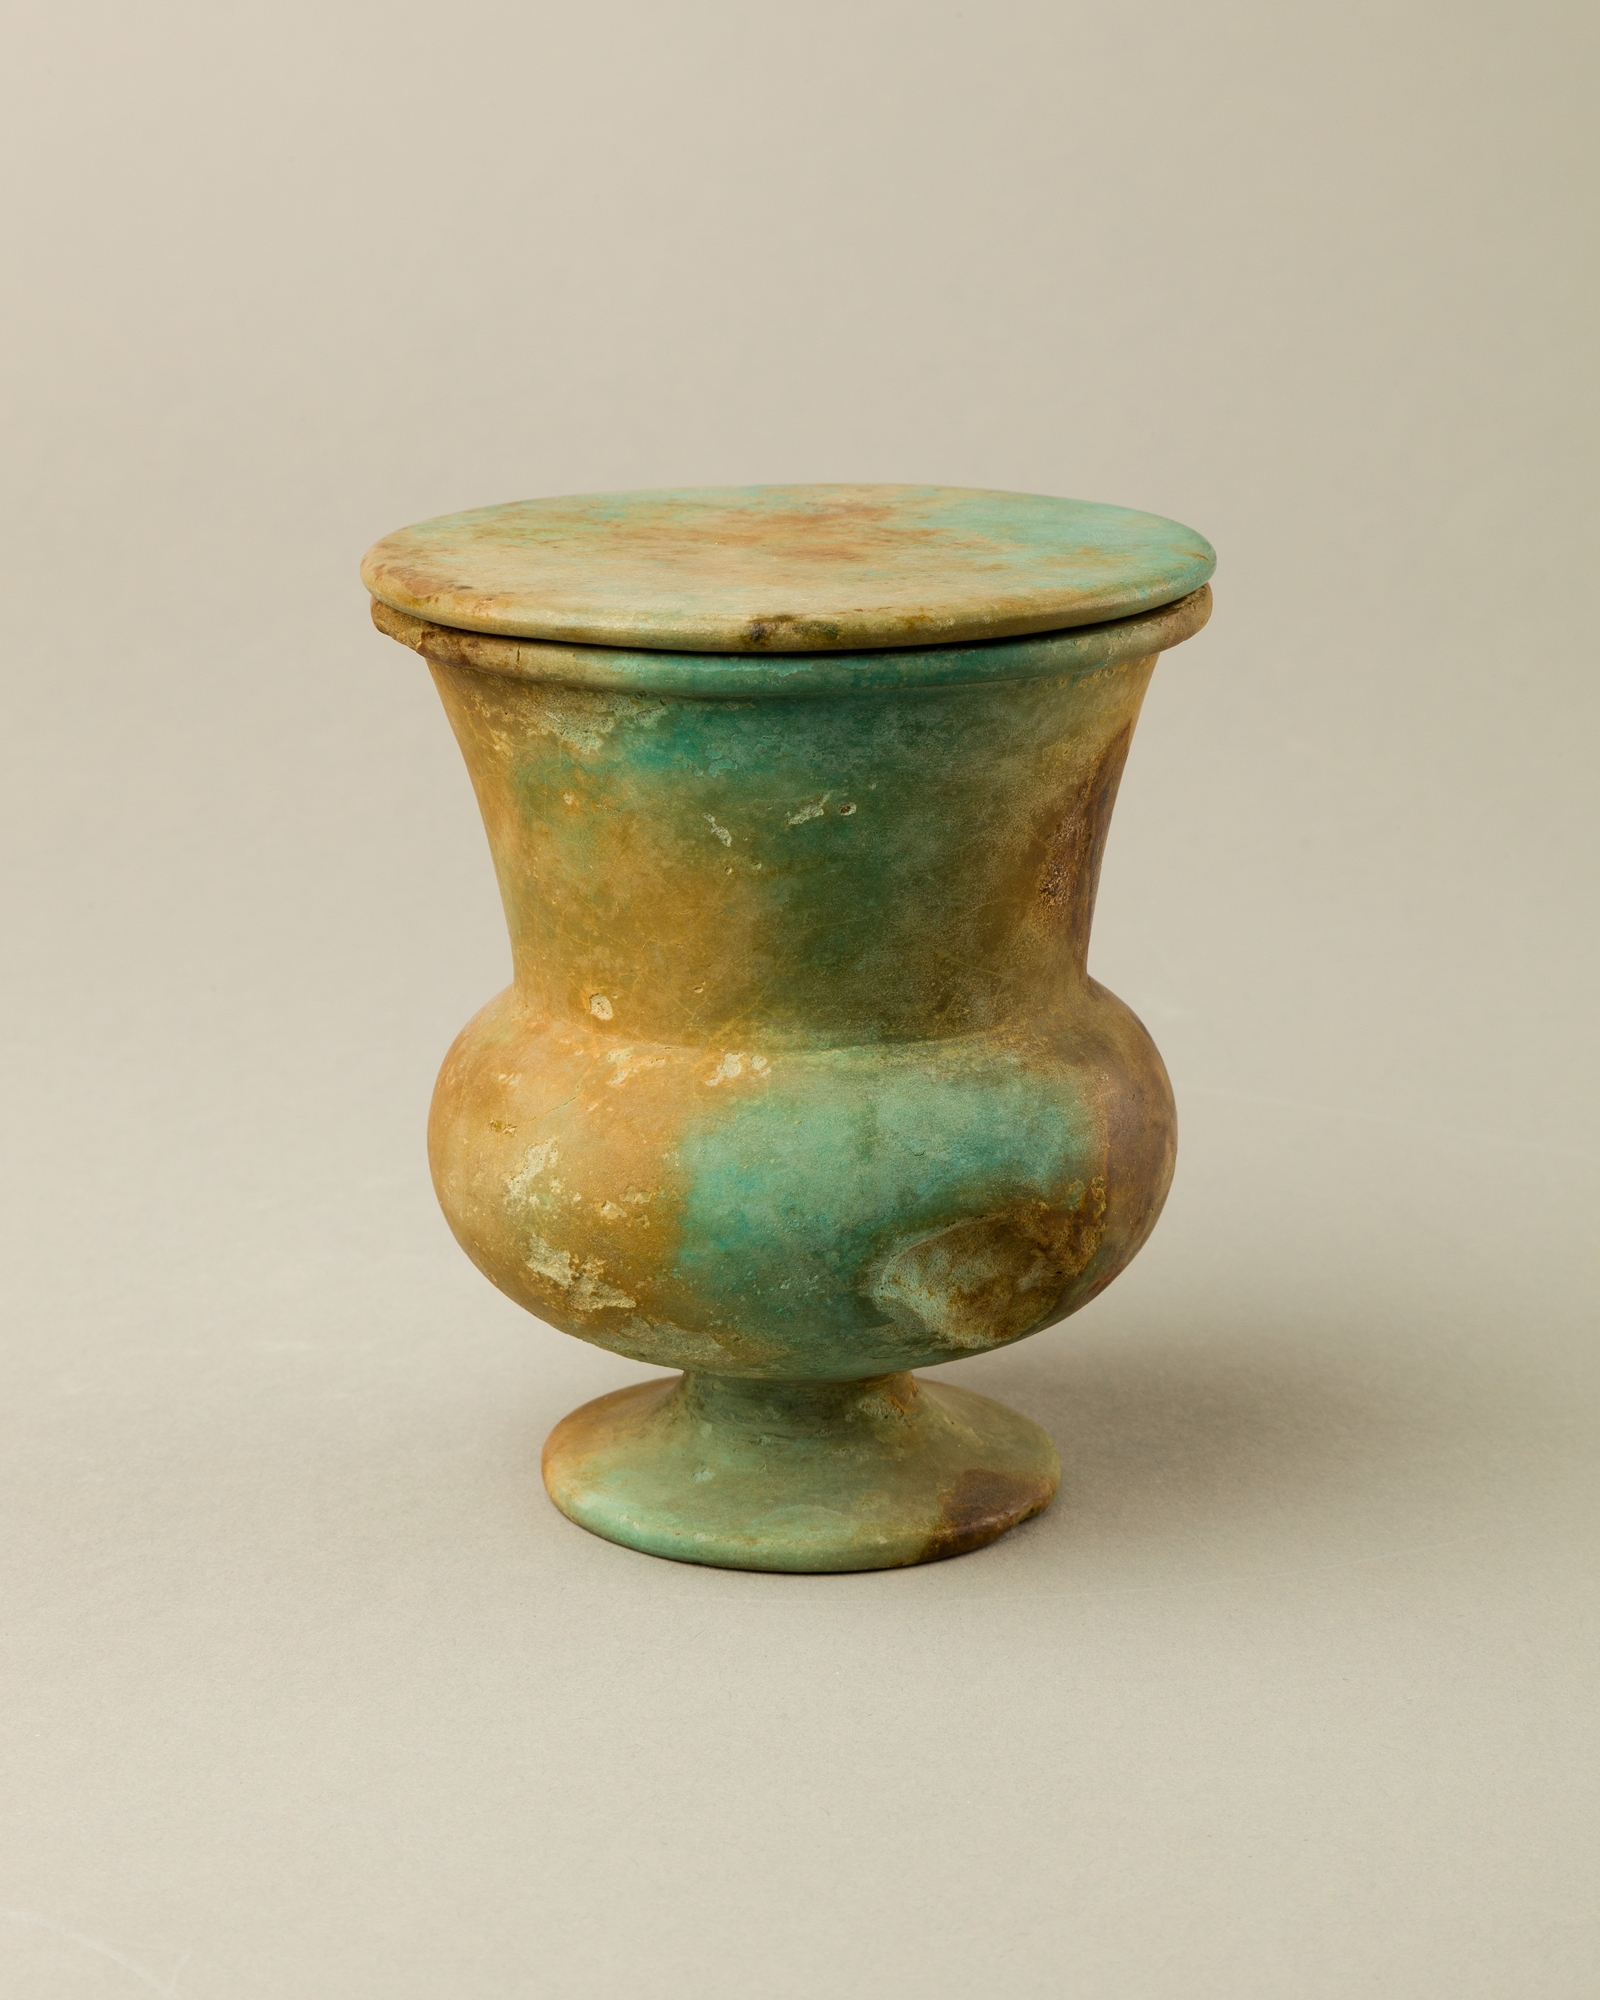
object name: cosmetic jar, open mouthed, neferkhawet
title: Open-Mouthed Cosmetic Jar of Neferkhawet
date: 1504-1447 BCE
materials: faience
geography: egypt